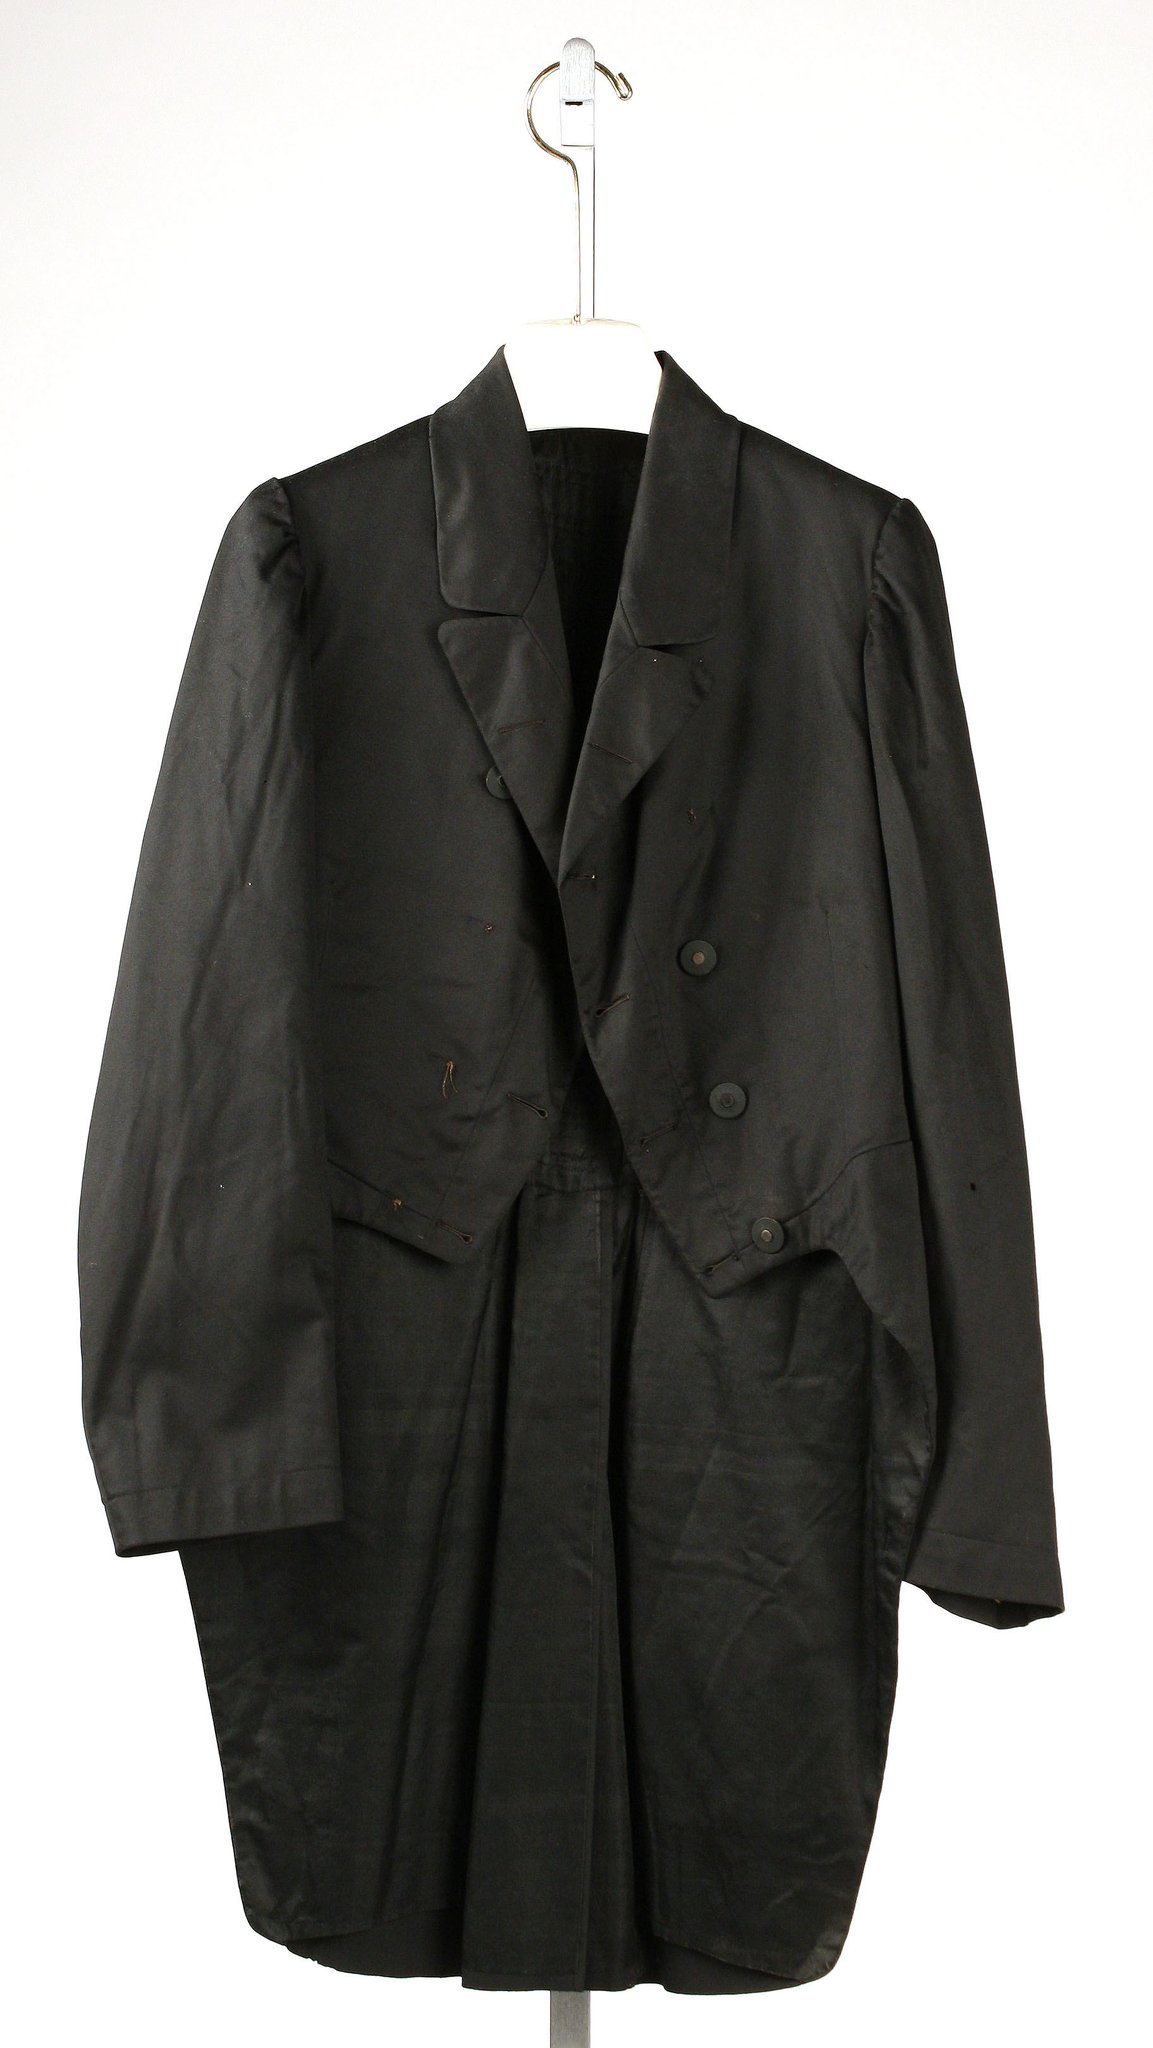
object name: tail coat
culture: american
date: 1860-1869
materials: wool